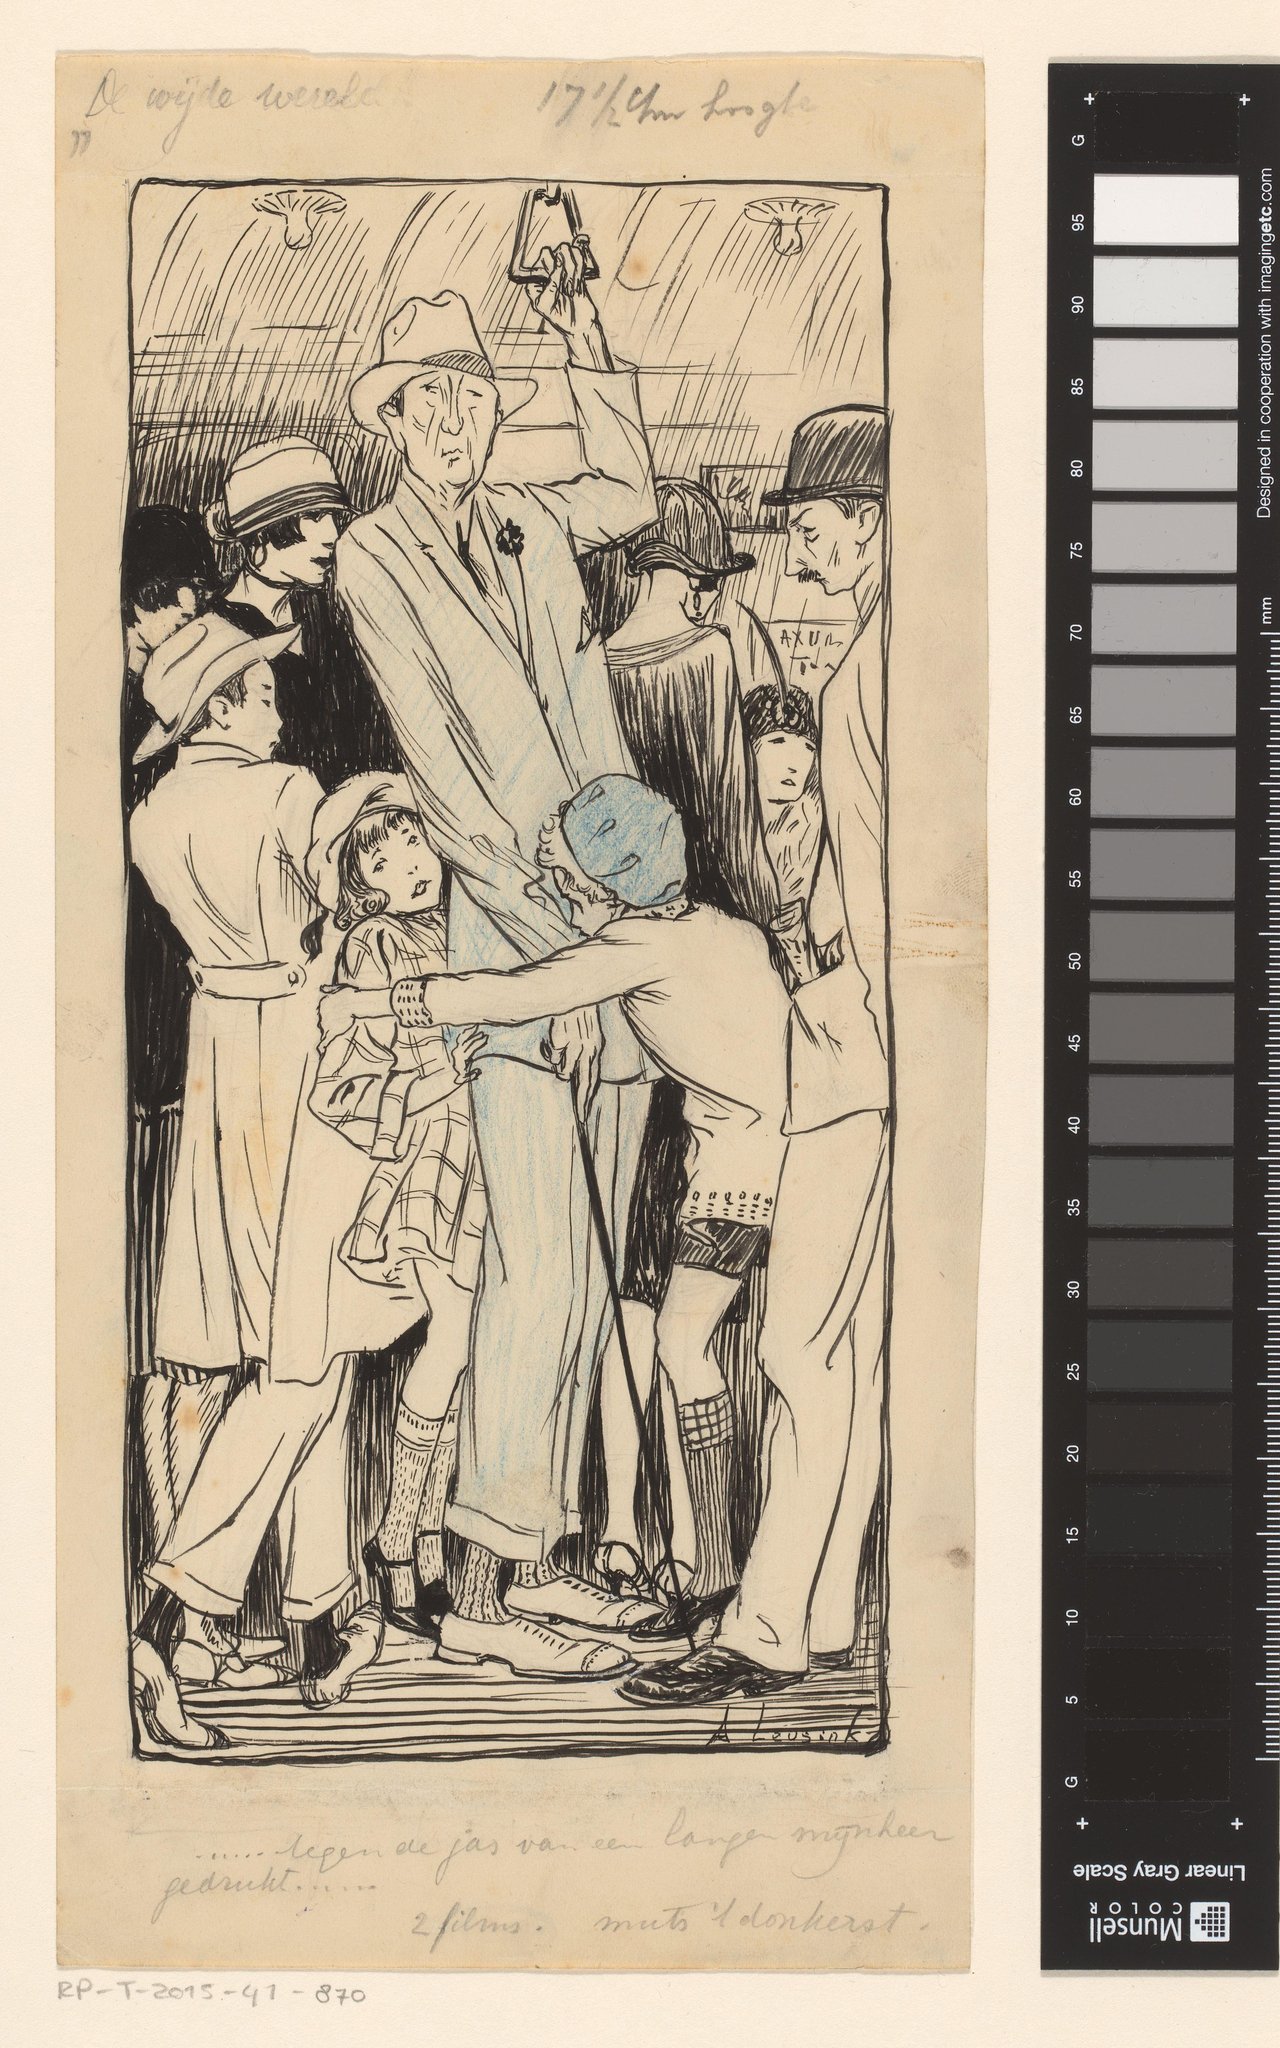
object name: drawing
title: Michette en Ton-ton worden platgedrukt in een metro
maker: anny leusink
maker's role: draughtsman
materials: ink, paper, pencil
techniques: pen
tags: crowd, mob, underground railway, 'métro'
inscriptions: annotation: ‘"De wijde wereld/ .... tegen de jas van een lange mijnheer/ gedrukt .....’, collector's mark: Lugt 2228, :, signature: ‘A Leusink’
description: Ontwerp voor: Dietz, Henriette e.a. De buitenpartij. Vertellingen voor jongens en meisjes. Amsterdam: Veen, 1926.